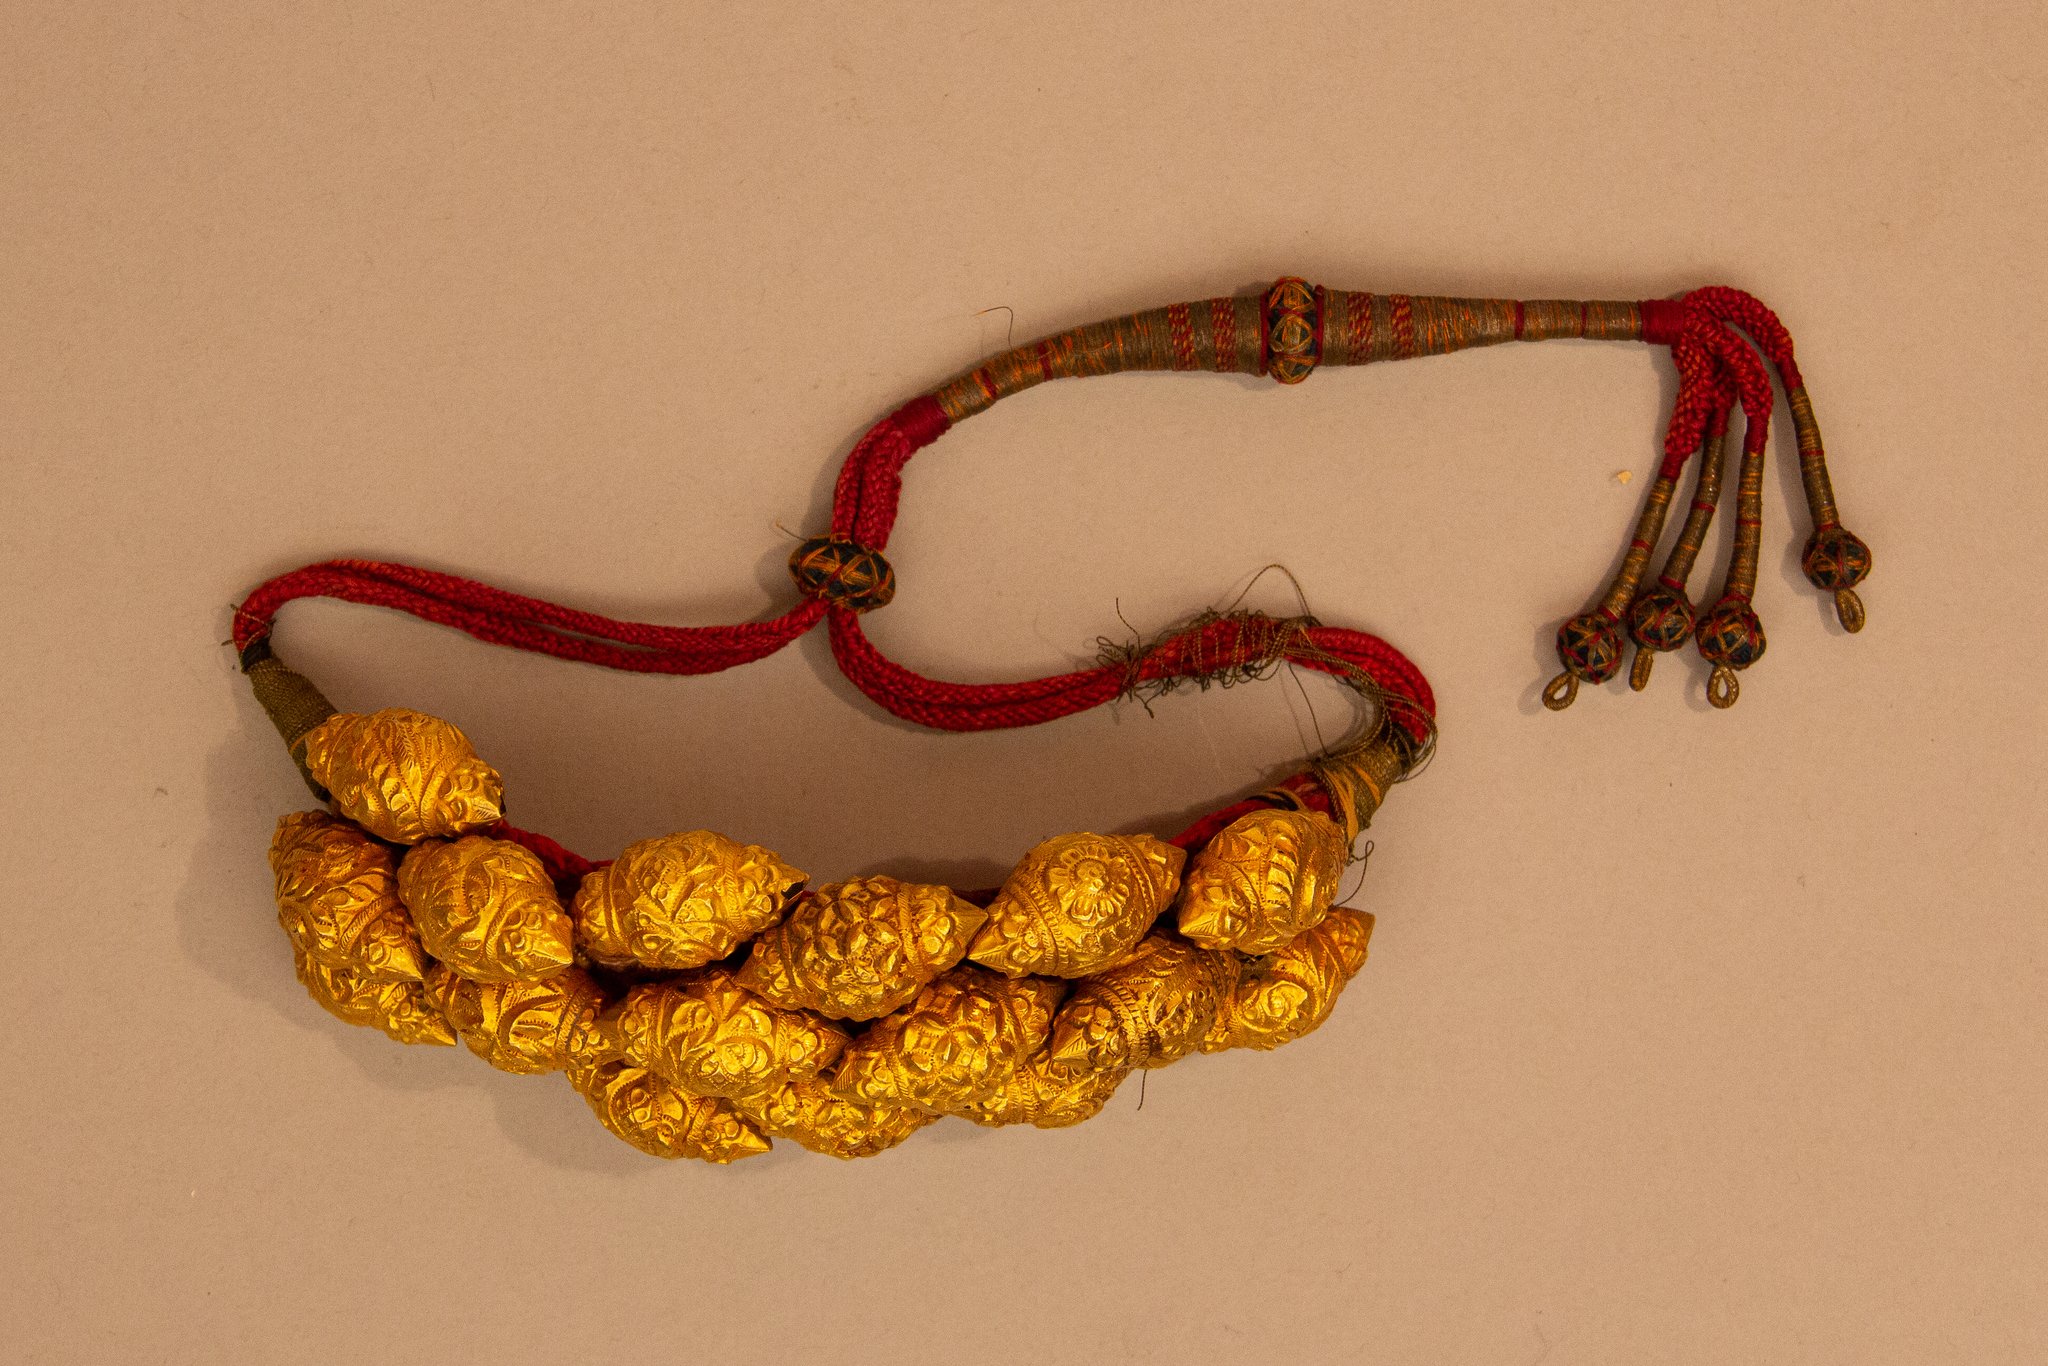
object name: bracelet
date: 1801-1900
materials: gold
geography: india